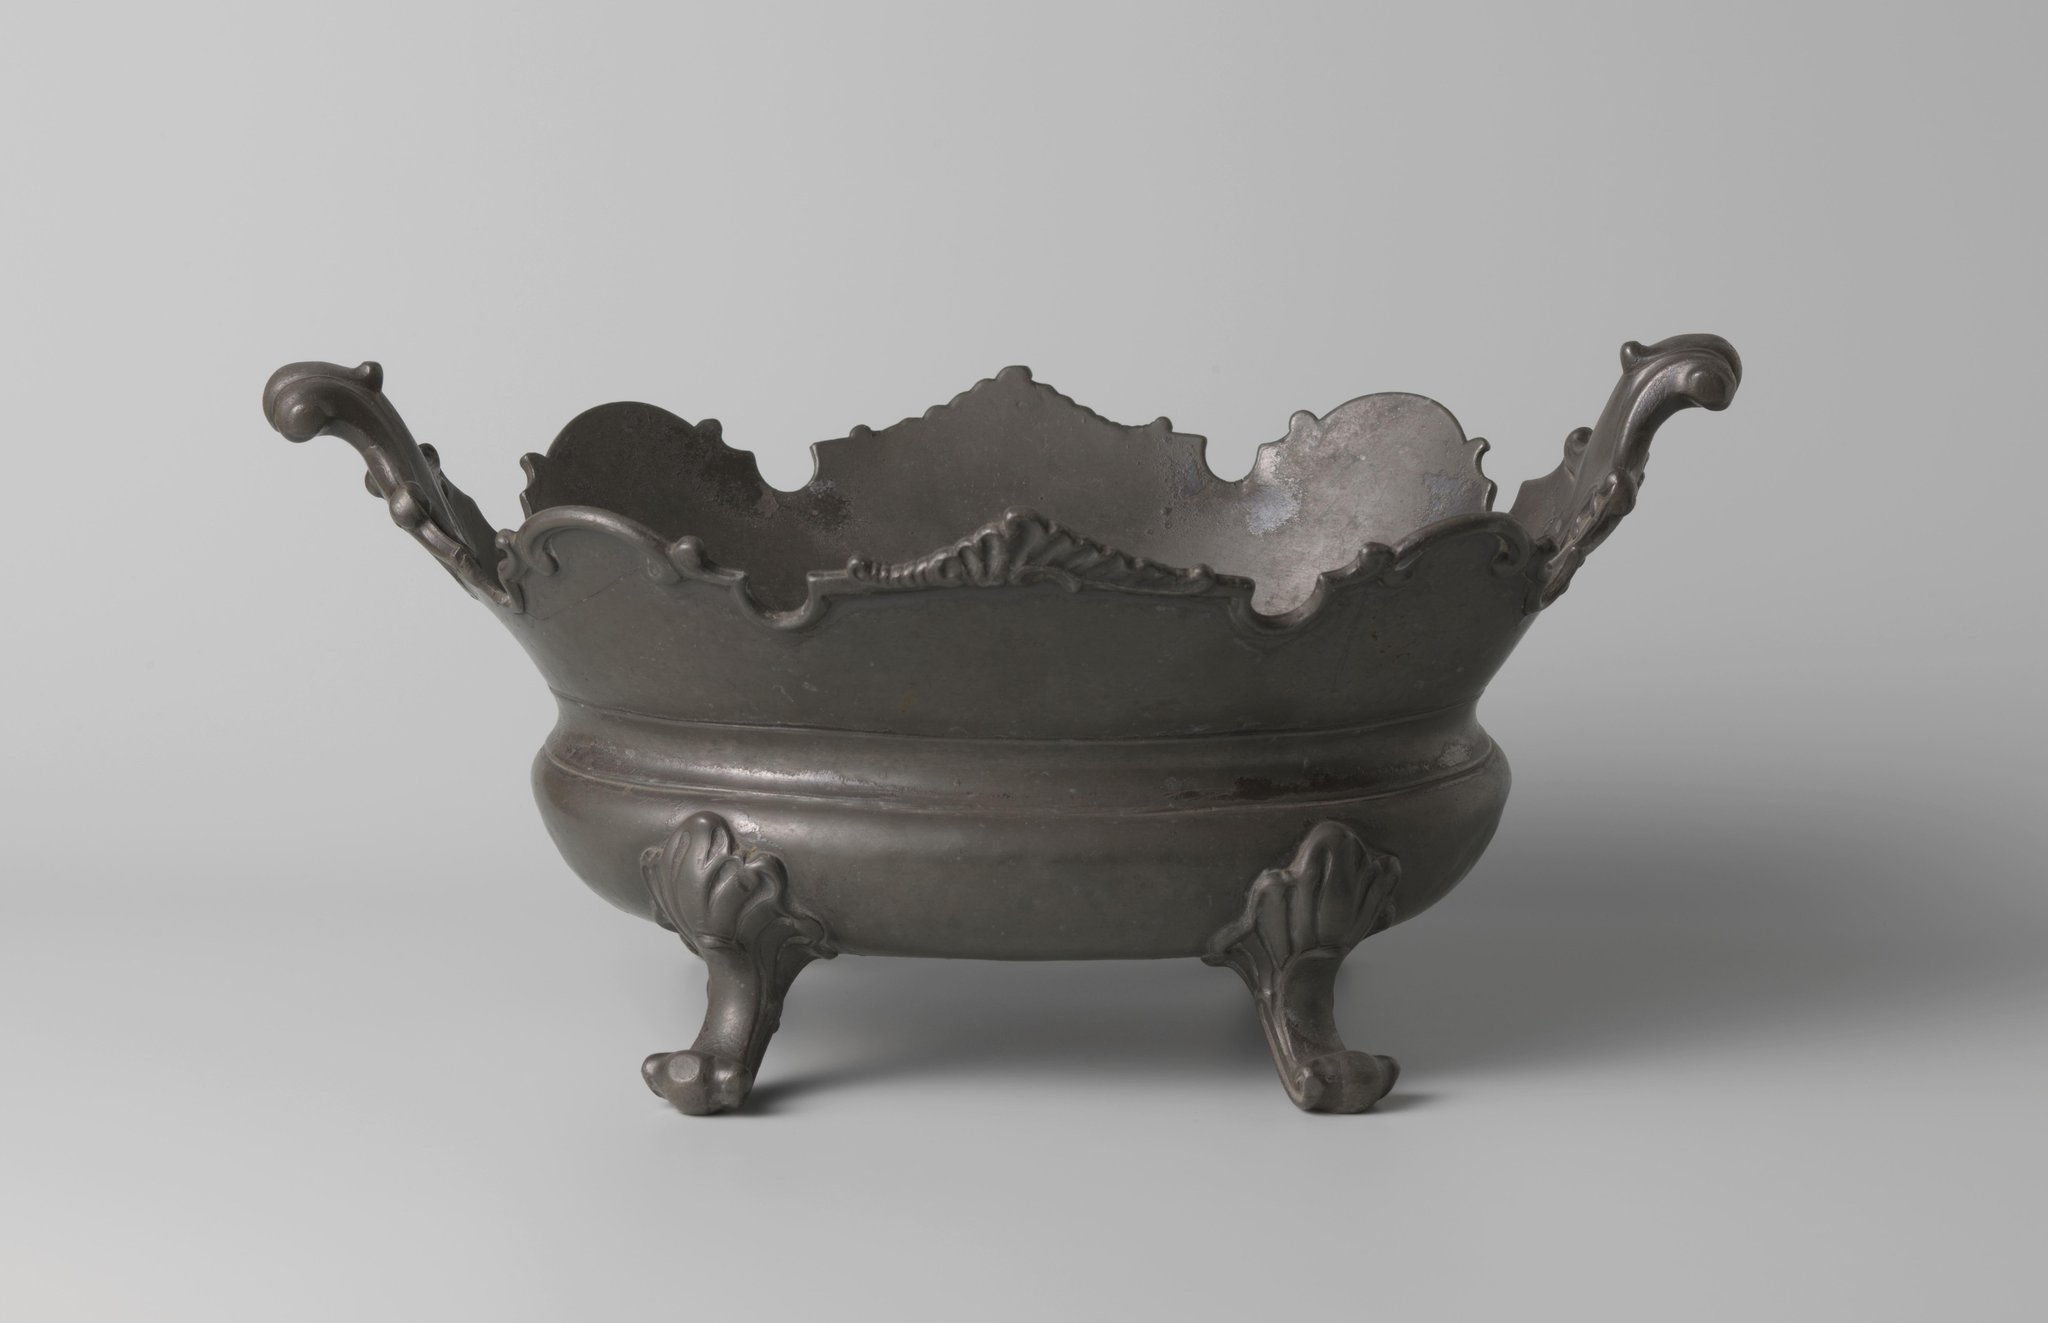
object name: wine cooler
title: Ovale wijnkoeler van tin op vier poten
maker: Anonymous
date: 1700-1800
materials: tin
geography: low countries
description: Ovale wijnkoeler van tin op vier gebogen poten. Het vat bestaat uit een bolle buik, een gladde wand en een gewelfd, zich verbredend bovengedeelte. Aan de bovenrand twee schuin opstaande oren uitlopend in een voluut. De rest van de bovenrand is dik aangezet en versierd.